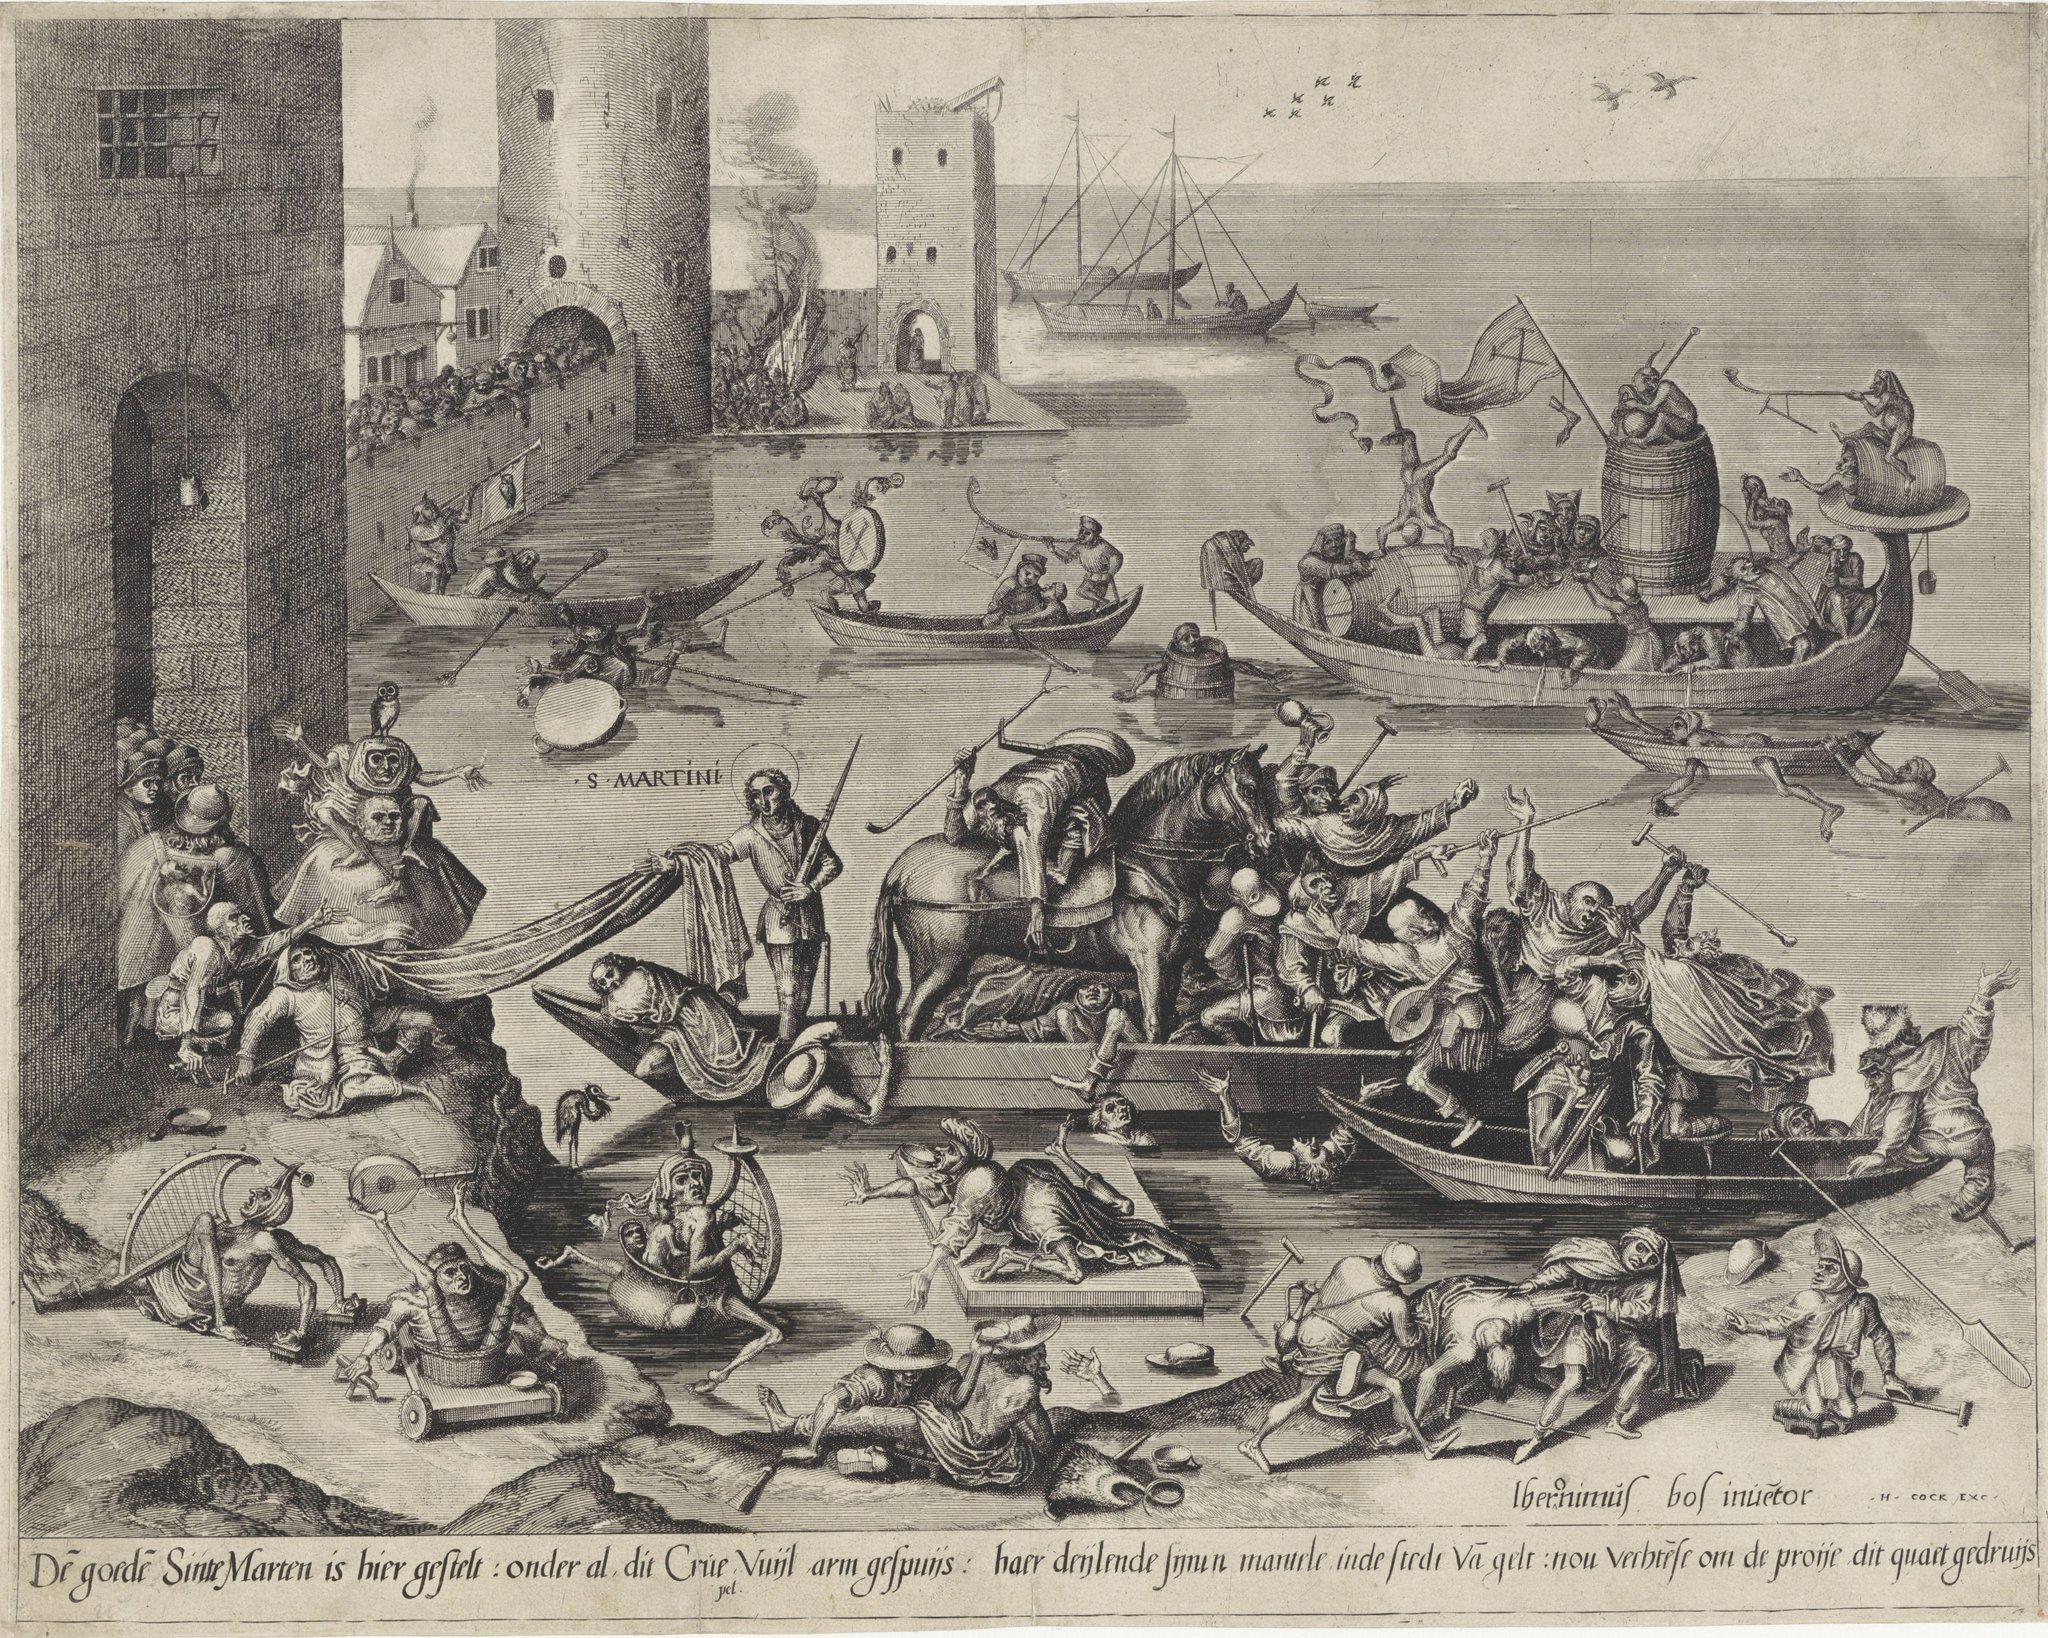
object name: print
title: H. Martinus aan boord van een narrenschip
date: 1548-1570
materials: paper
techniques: engraving, etching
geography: den bosch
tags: person with a physical disability, disabilities, deformations, the poor, martin(us), bishop of tours; possible attributes: beggar, goose, ship of fools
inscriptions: collector's mark: Lugt 2228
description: H. Martinus staat achter zijn paard op een narrenschip. Over zijn arm hangt zijn mantel, die door bedelaars aan wal wordt vastgehouden. Enkele narren zijn in gevecht met narren in een roeiboot, die naast het narrenschip ligt. Aan de waterkant lopen, kruipen en rollen enkele figuren, die in de tekst in de marge aangeduid worden als ‘kreupel, vuil en arm gespuis’. Op de achtergrond varen nog enkele boten. Links kijken figuren vanaf een vesting toe. Onder de voorstelling in de marge een éénregelig onderschrift in het Nederlands.